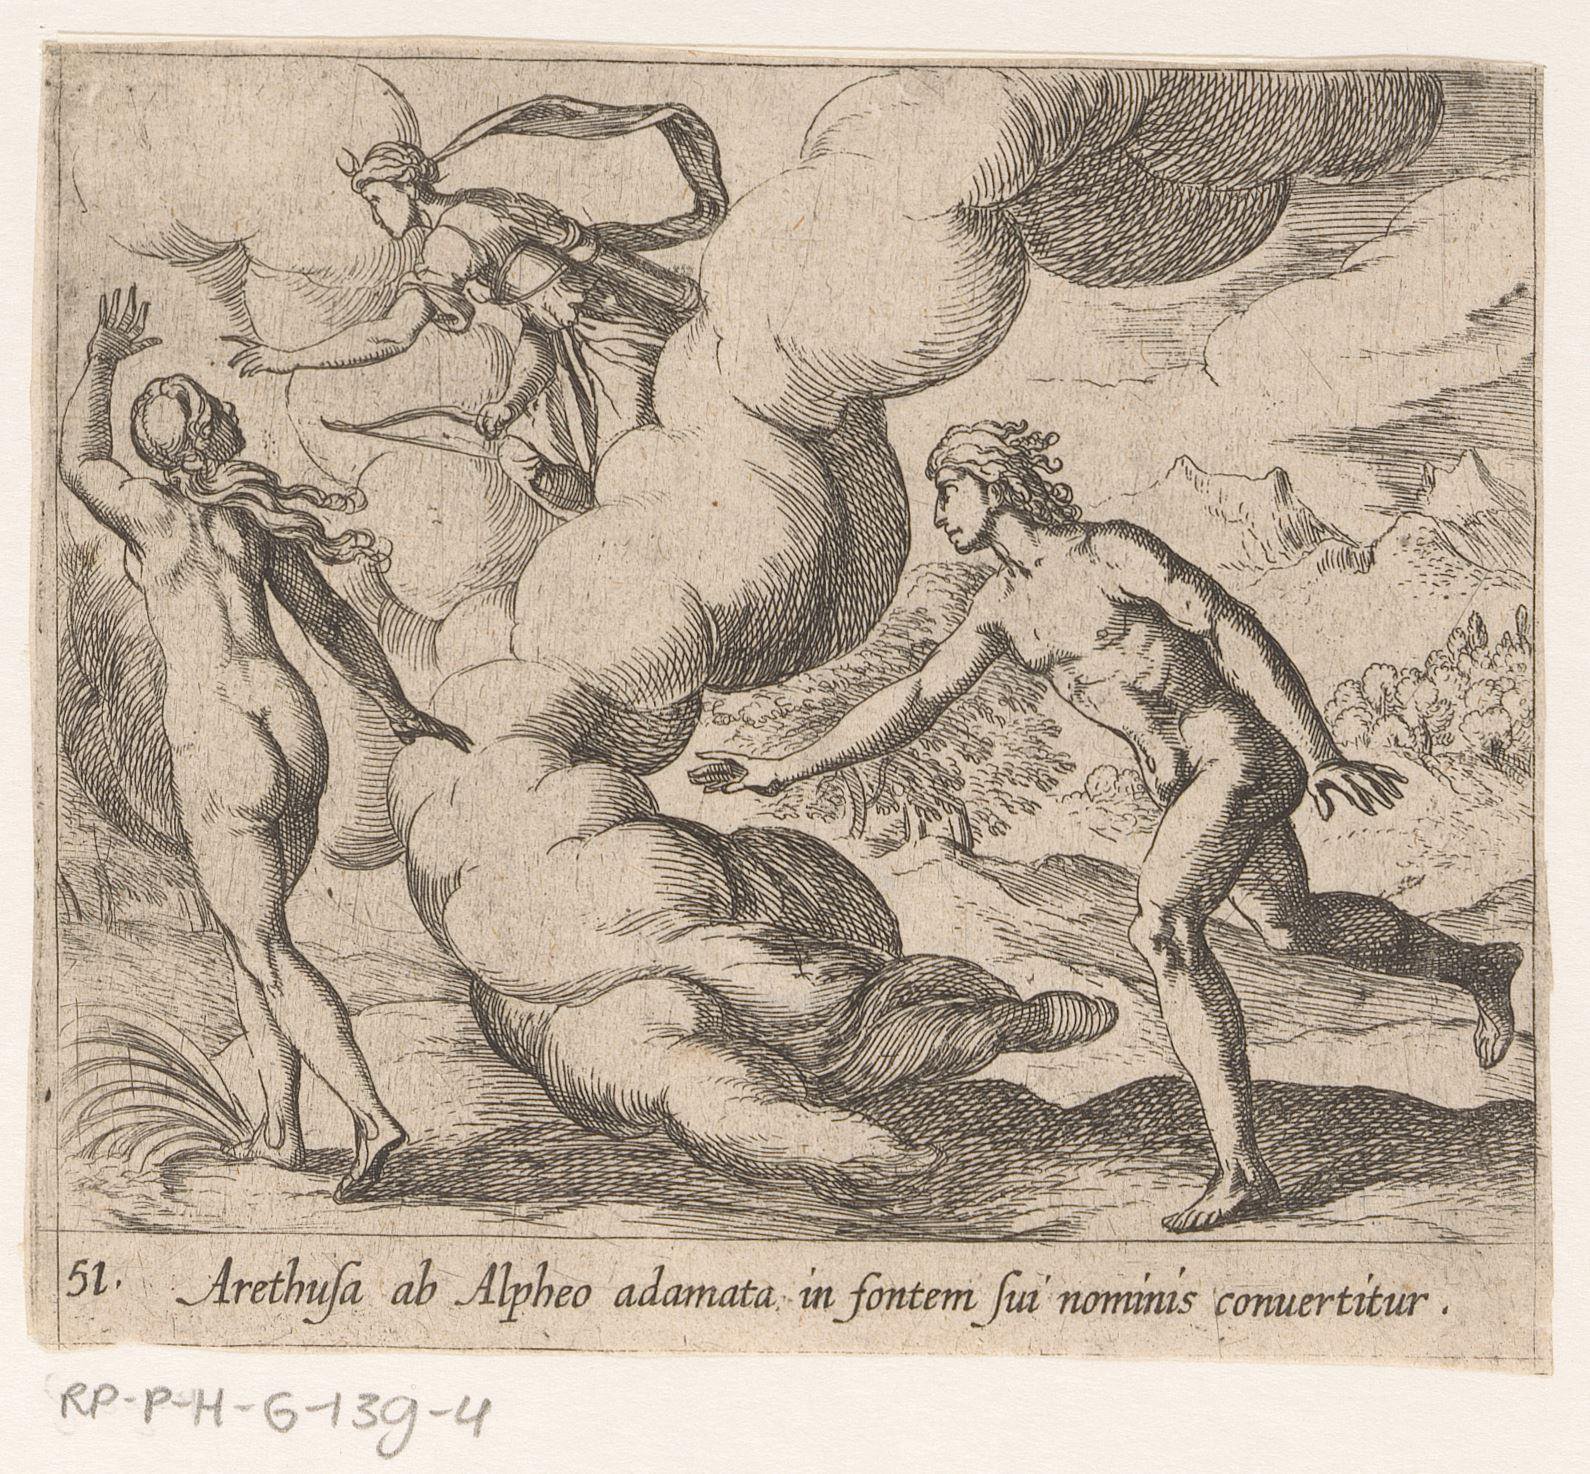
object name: print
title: Arethusa ab Alpheo adamata in fontem sui nominis convertitur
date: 1606-1638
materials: paper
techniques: etching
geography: italy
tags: arethusa is turned into a fountain when pursued by the handsome hunter alpheus (pausanias v 7, 2)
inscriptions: collector's mark: ‘Hinloopen’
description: Deze prent maakt deel uit van een reeks van 150 prenten (+ titelprent) met voorstellingen van de Metamorfosen van Ovidius.